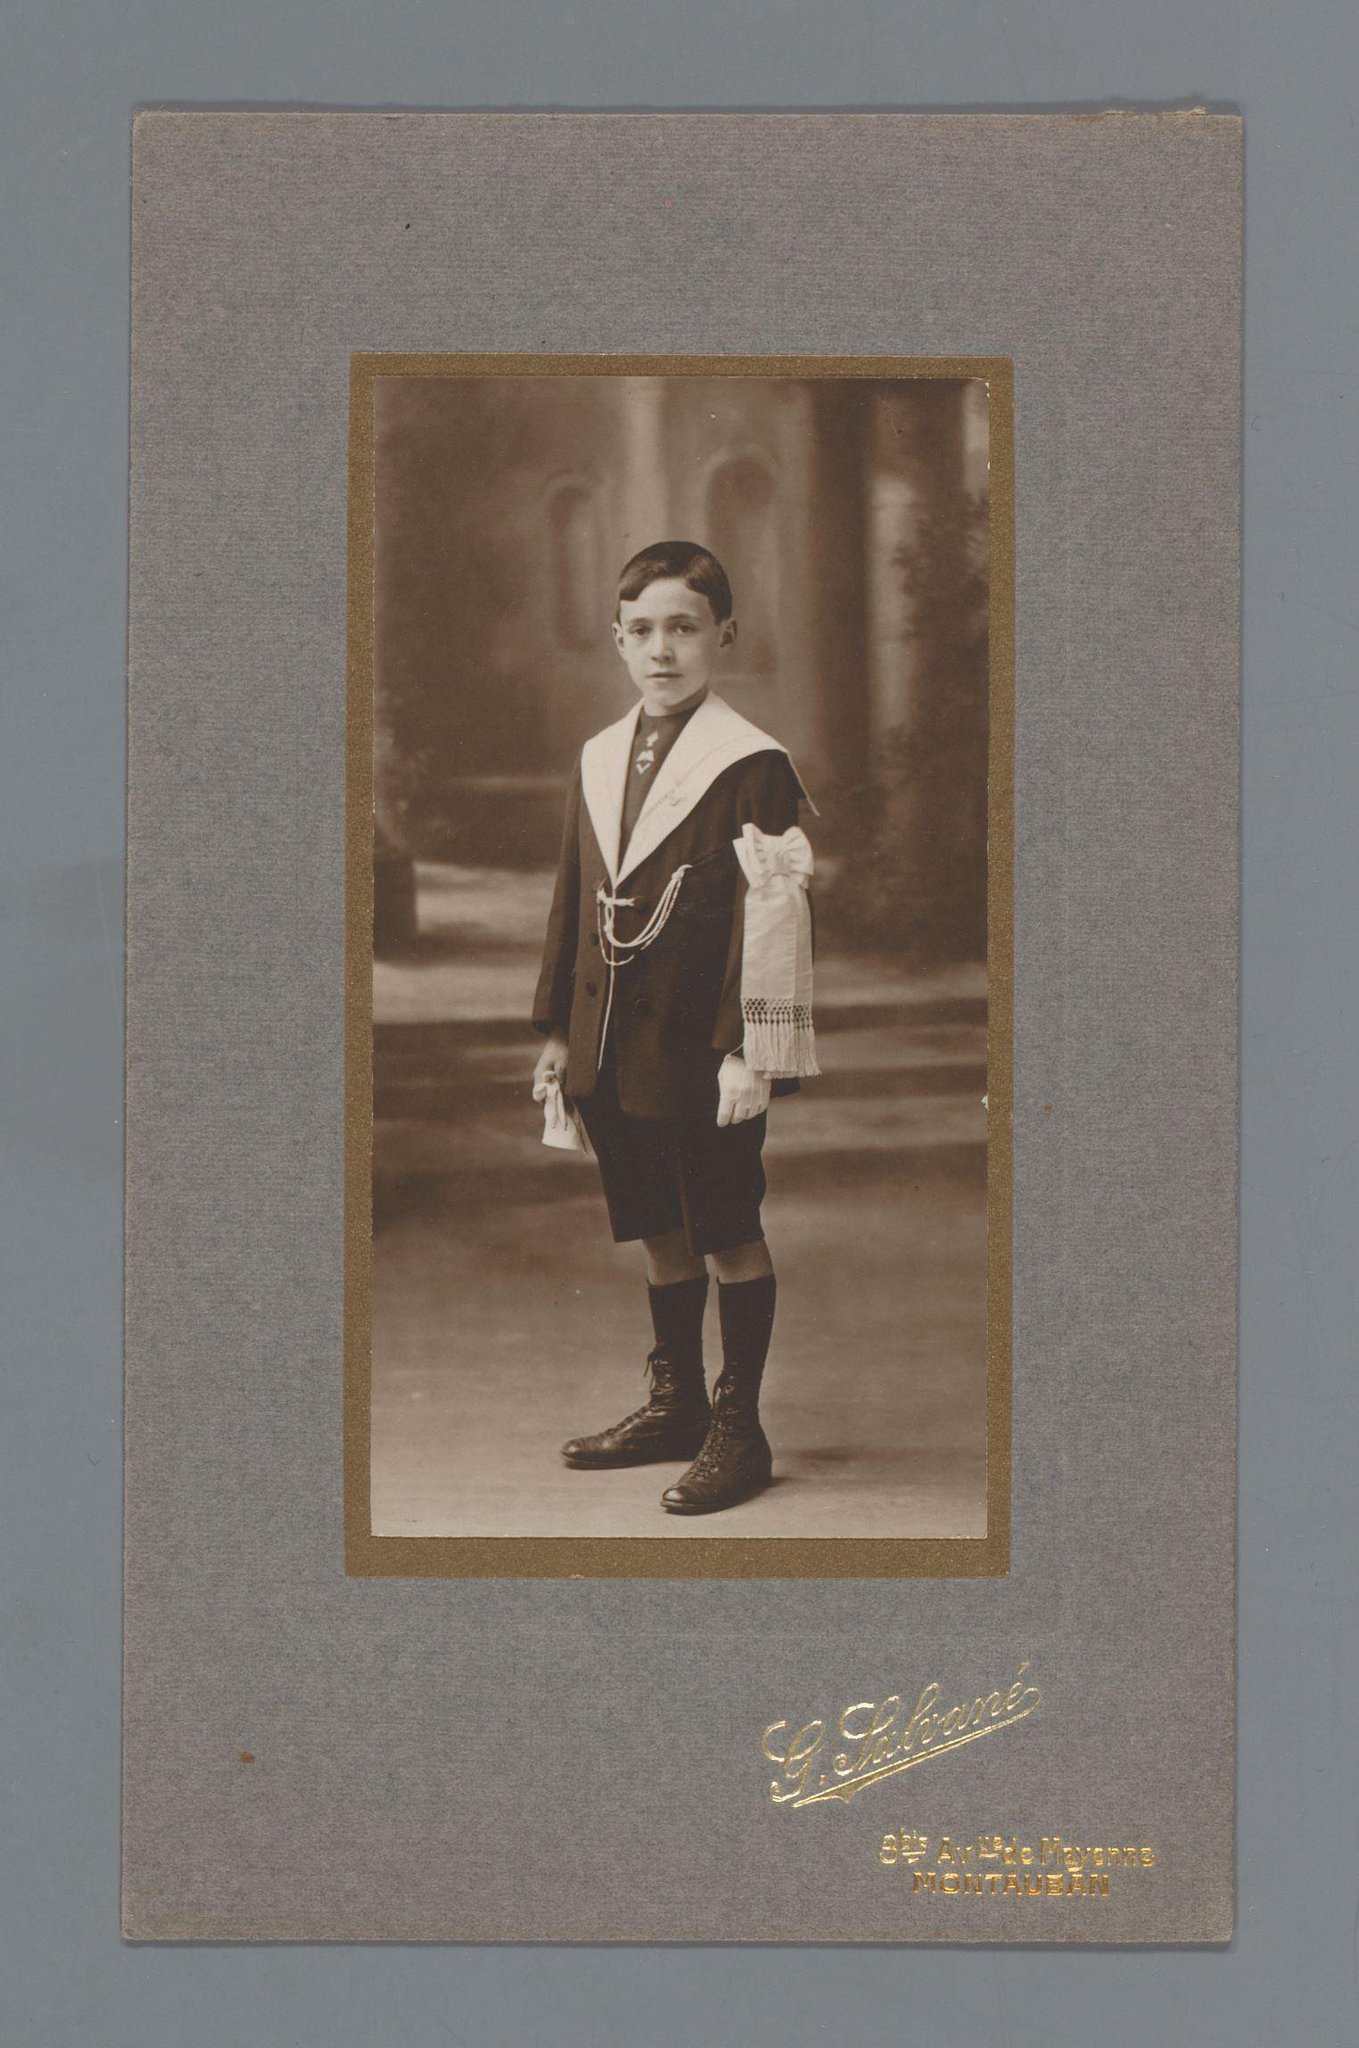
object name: photograph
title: Portret van een onbekende jongen in communiekleding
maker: g. salvane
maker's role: fotograaf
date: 1900-1915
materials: cardboard, photographic support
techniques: gelatin silver print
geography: montauban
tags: communion dress, boy (child between toddler and youth)